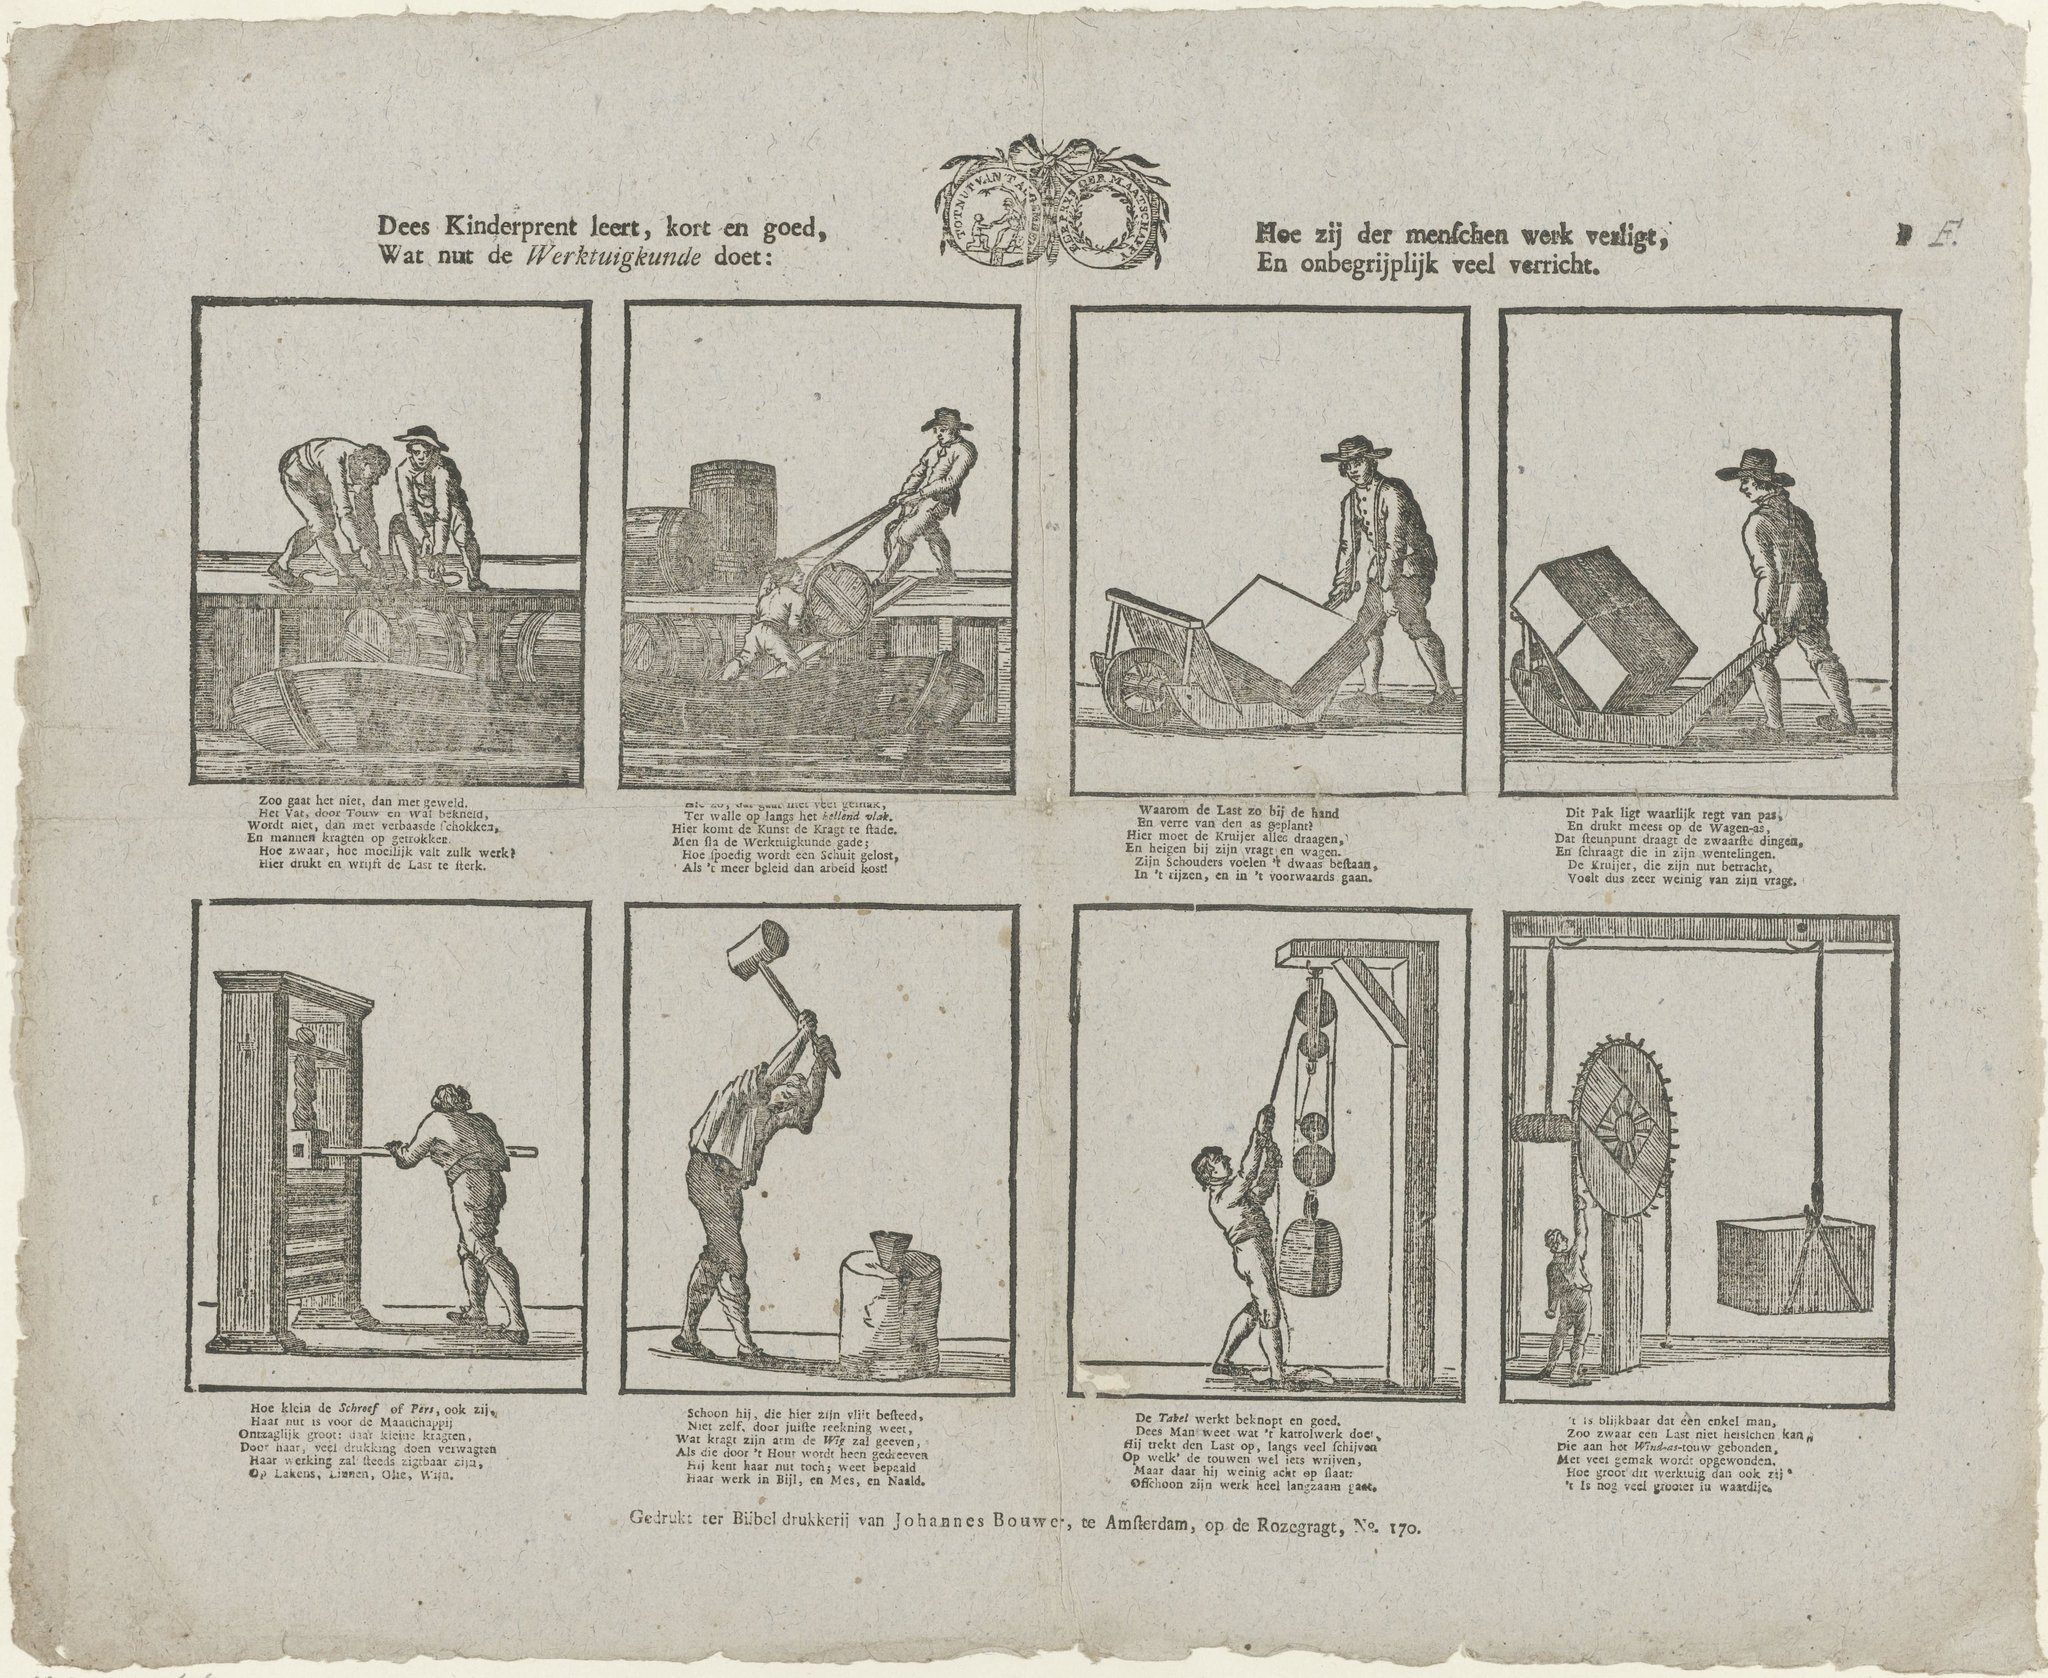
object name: print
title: Dees kinderprent leert, kort en goed, / Wat nut de werktuigkunde doet: / Hoe zij der menschen werk verligt, / En onbegrijplijk veel verricht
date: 1805-1808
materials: paper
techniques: letterpress printing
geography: netherlands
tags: tools and machines ~ building, dynamics, kinetics, printing press, dock crane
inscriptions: collector's mark: Lugt 2760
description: Blad met 8 voorstellingen van mannen die werktuigen gebruiken, zoals een pers en een hijskraan. Midden boven het zegel van de Maatschappij tot Nut van 't Algemeen. Onder elke afbeelding een zesregelig vers. Genummerd rechtsboven: F.